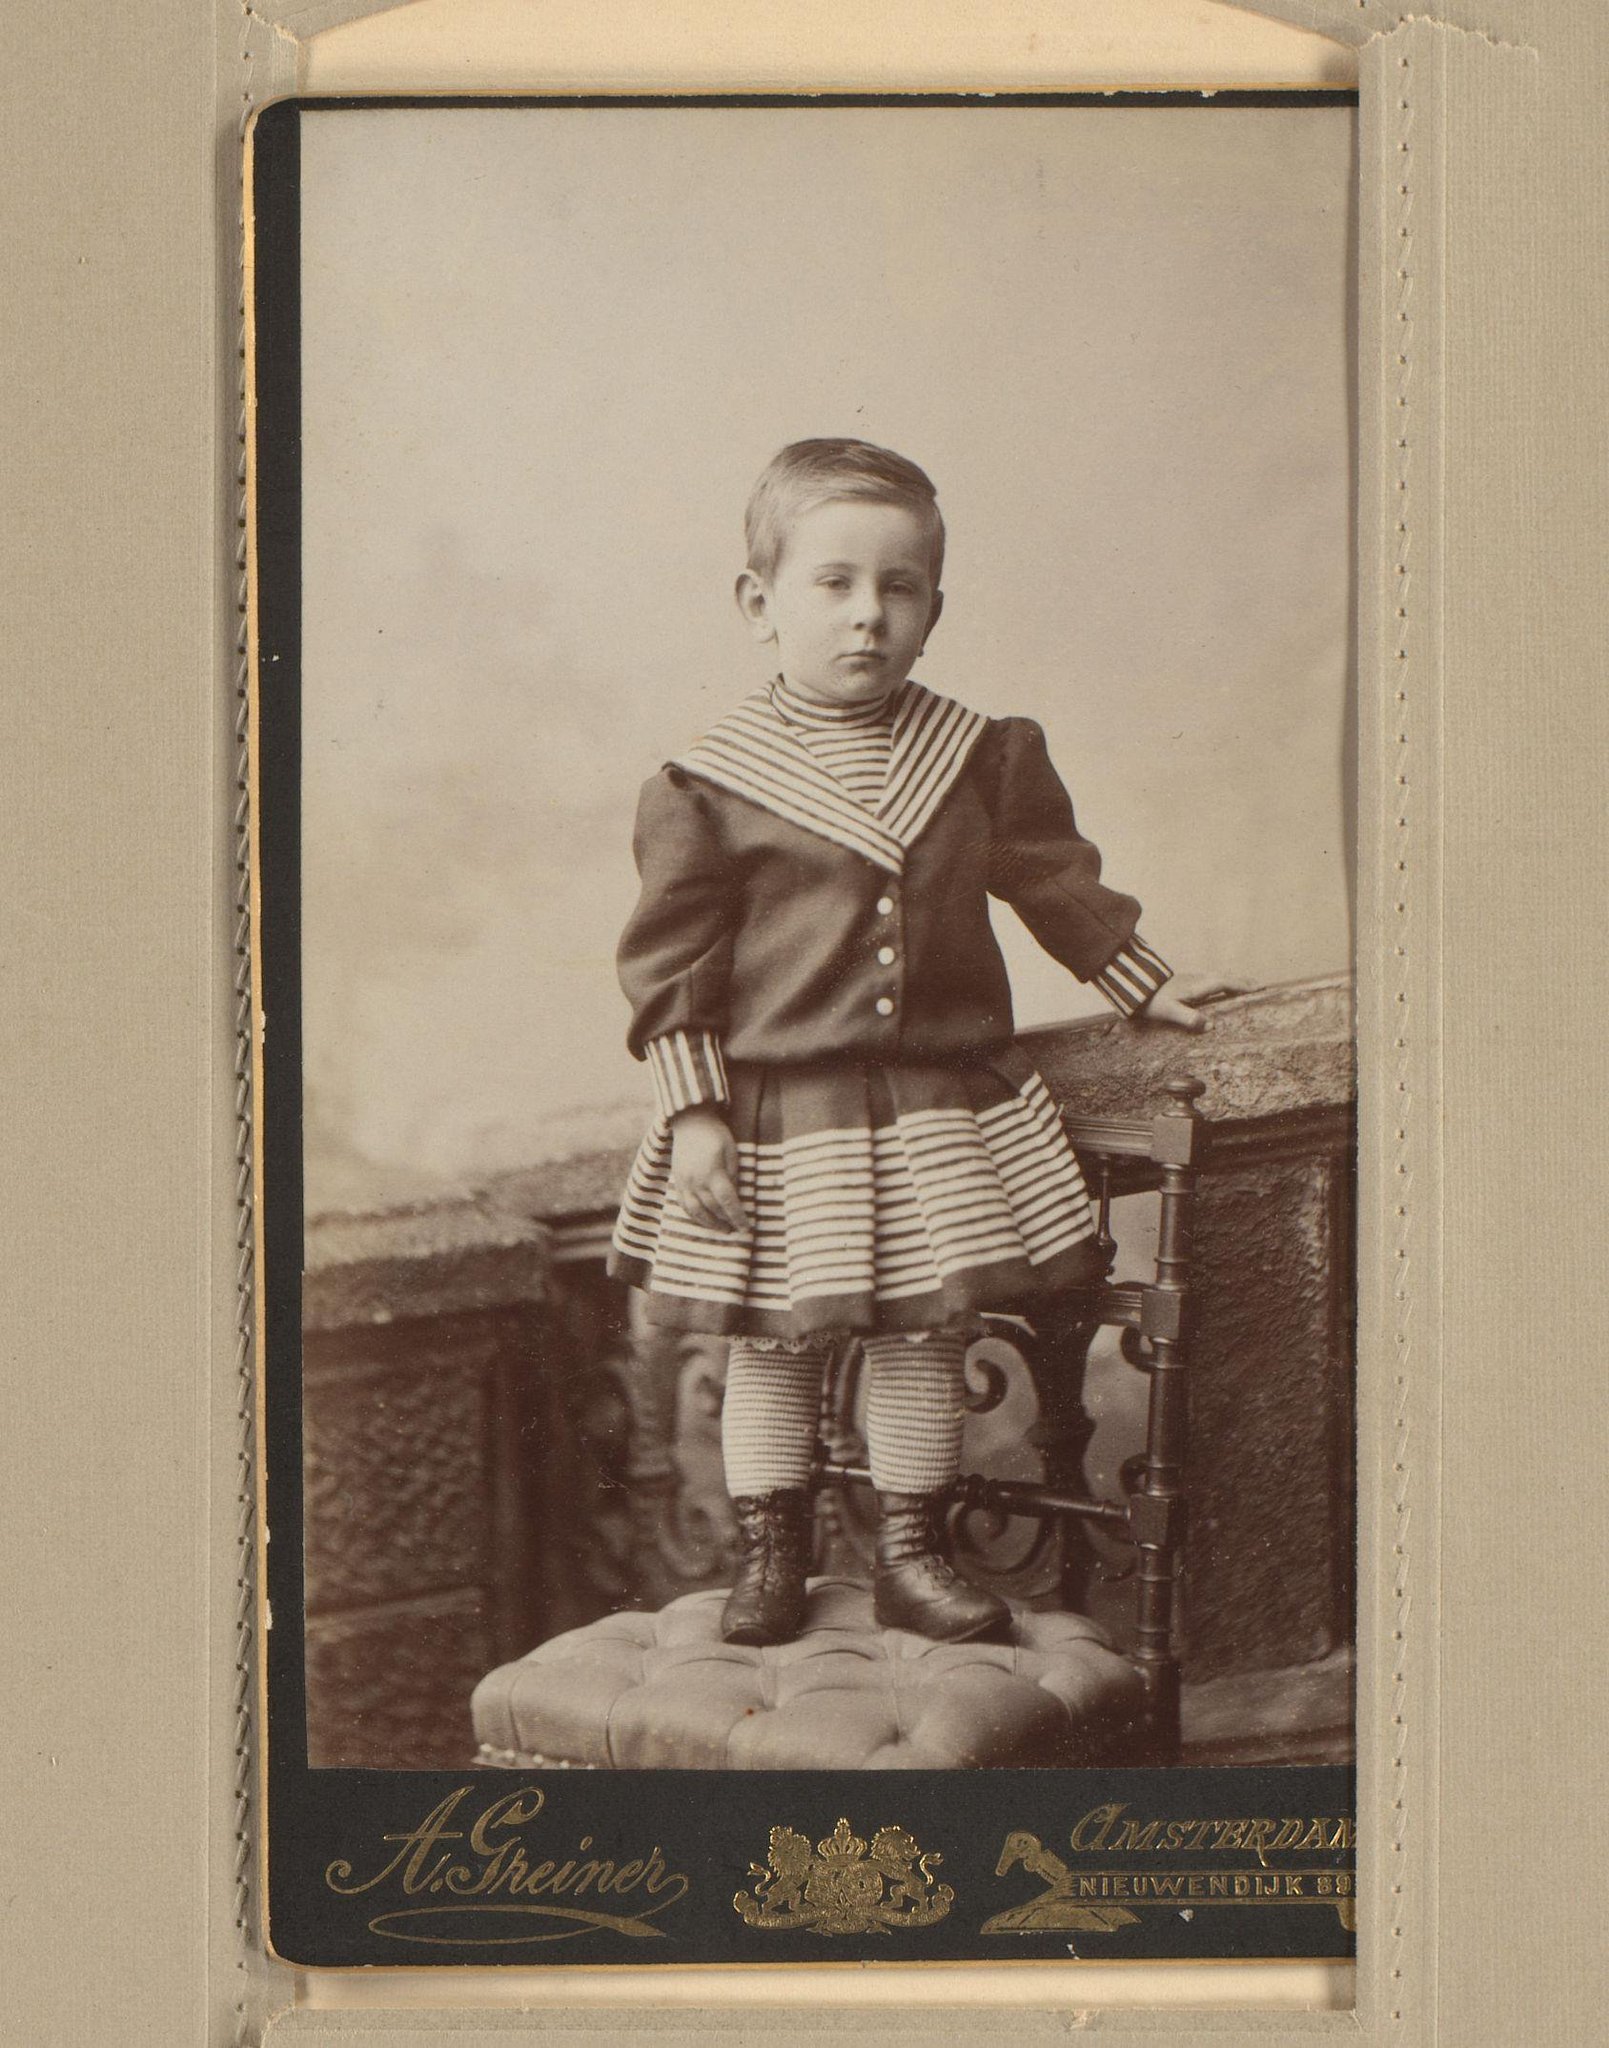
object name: cabinet photograph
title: Studioportret van een jonge Guus Kessler op een stoel naast een balustrade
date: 1885-1900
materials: paper, photographic support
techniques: albumen print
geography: amsterdam